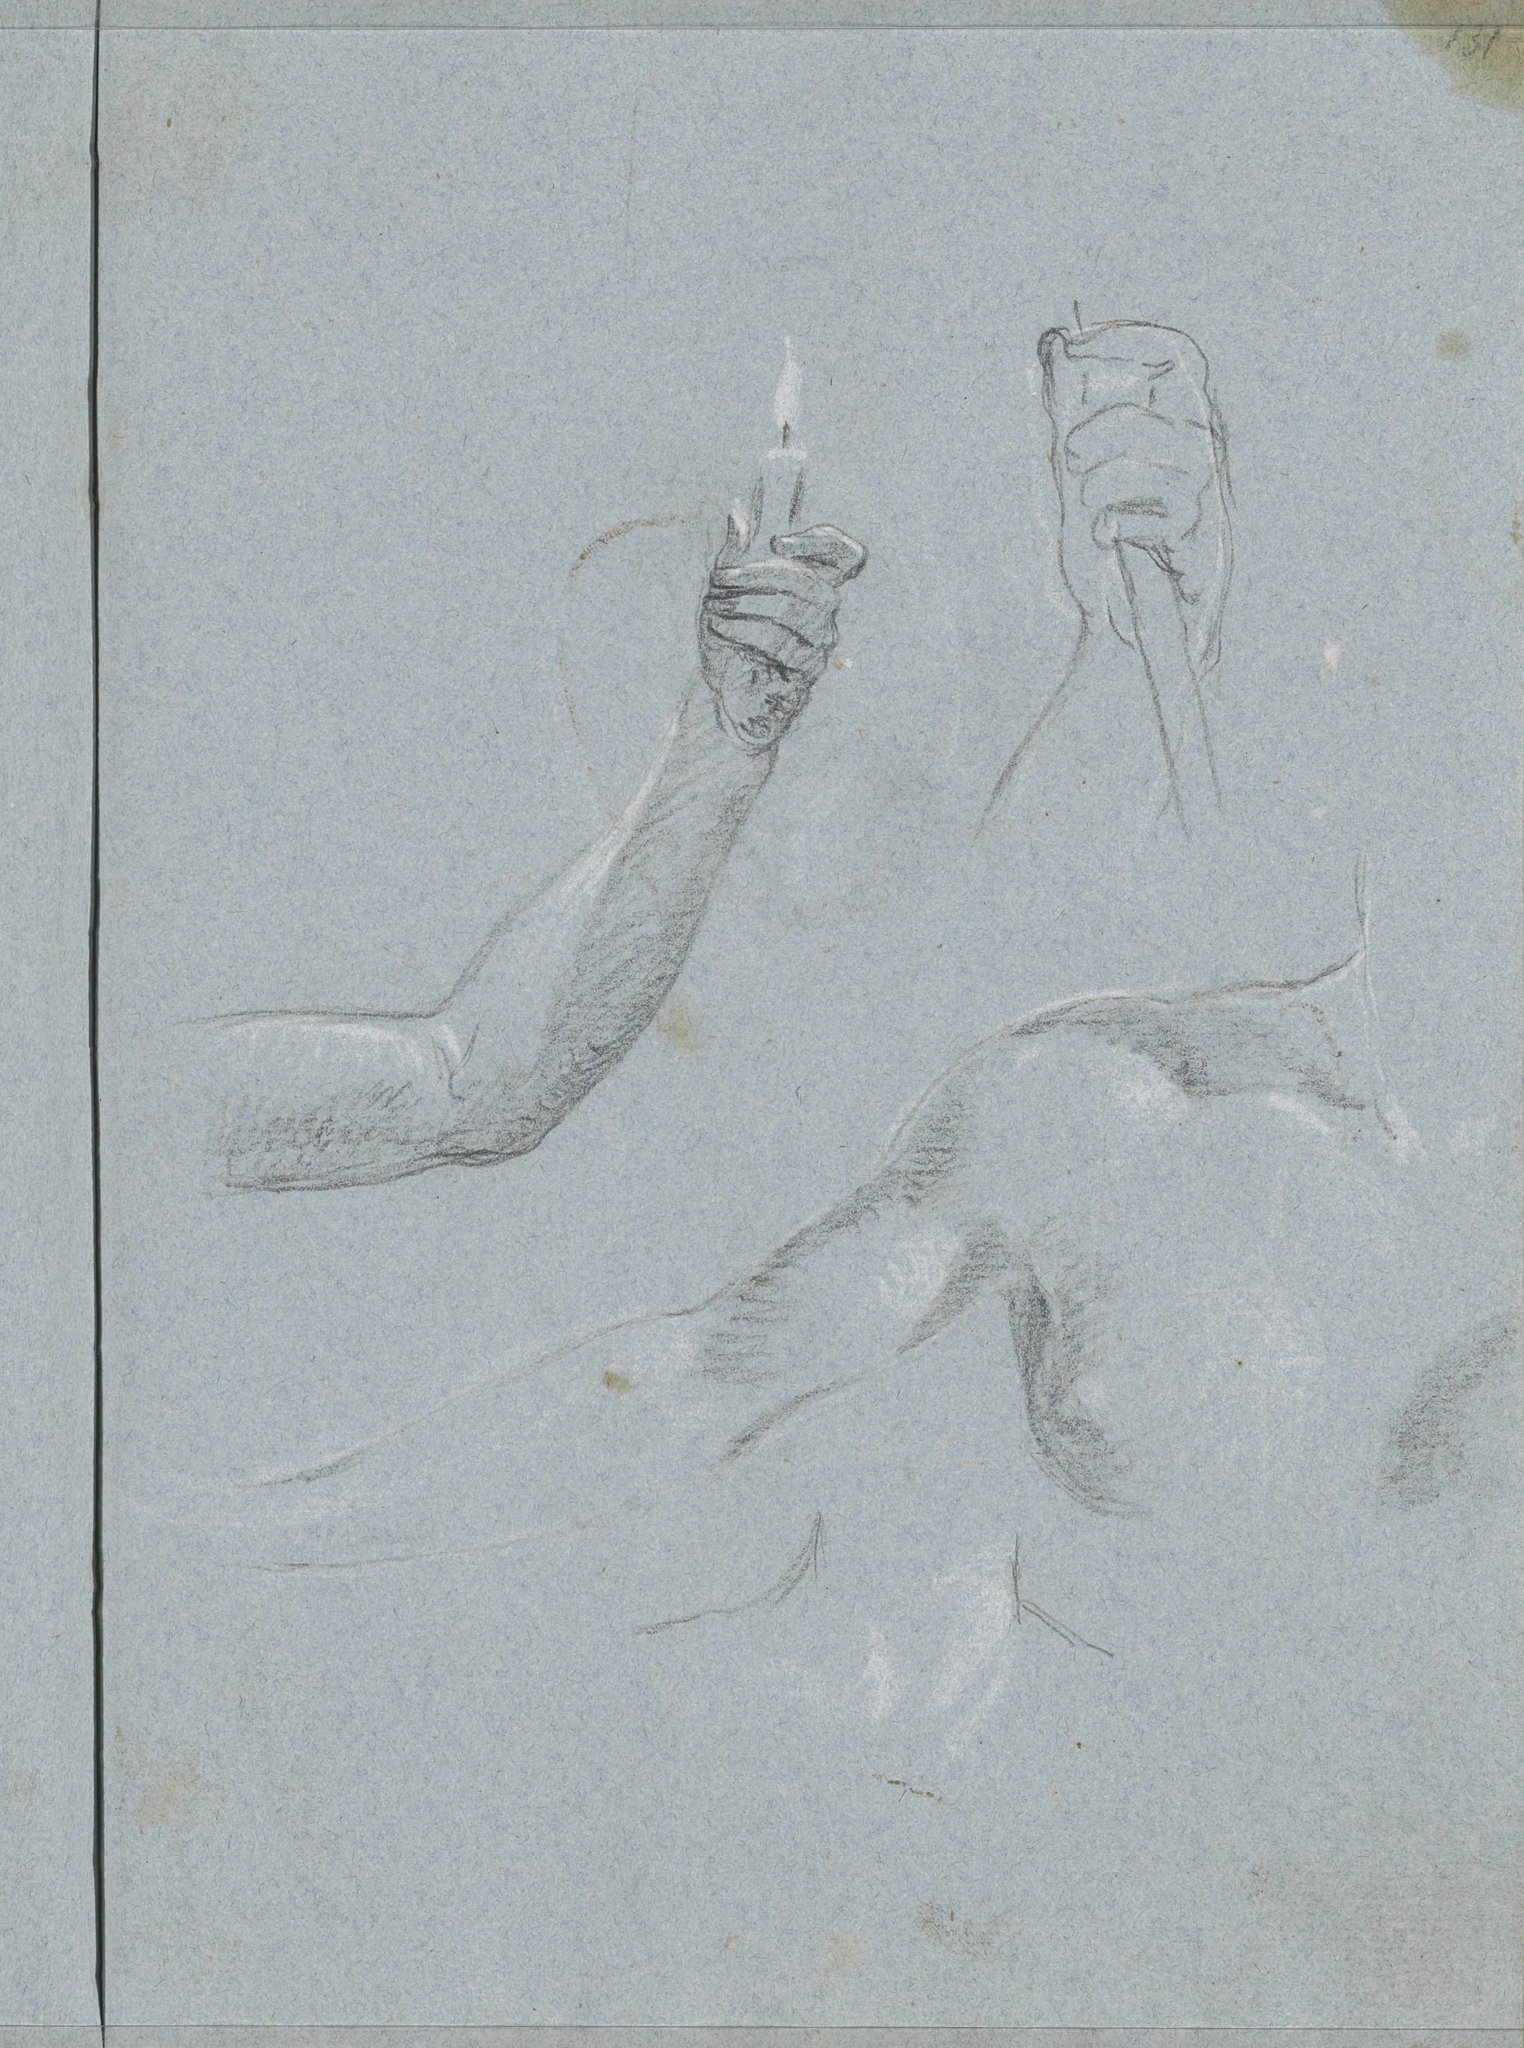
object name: sketchbook leaf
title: Hand met een kaars en stok en een schouder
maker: lorenzo baldissera tiepolo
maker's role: draughtsman, print maker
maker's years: 1736-1776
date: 1751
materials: chalk, paper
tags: hand, shoulder - aa - female human figure, candle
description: Bladzijde 131 uit een schetsboek met 158 bladzijden.